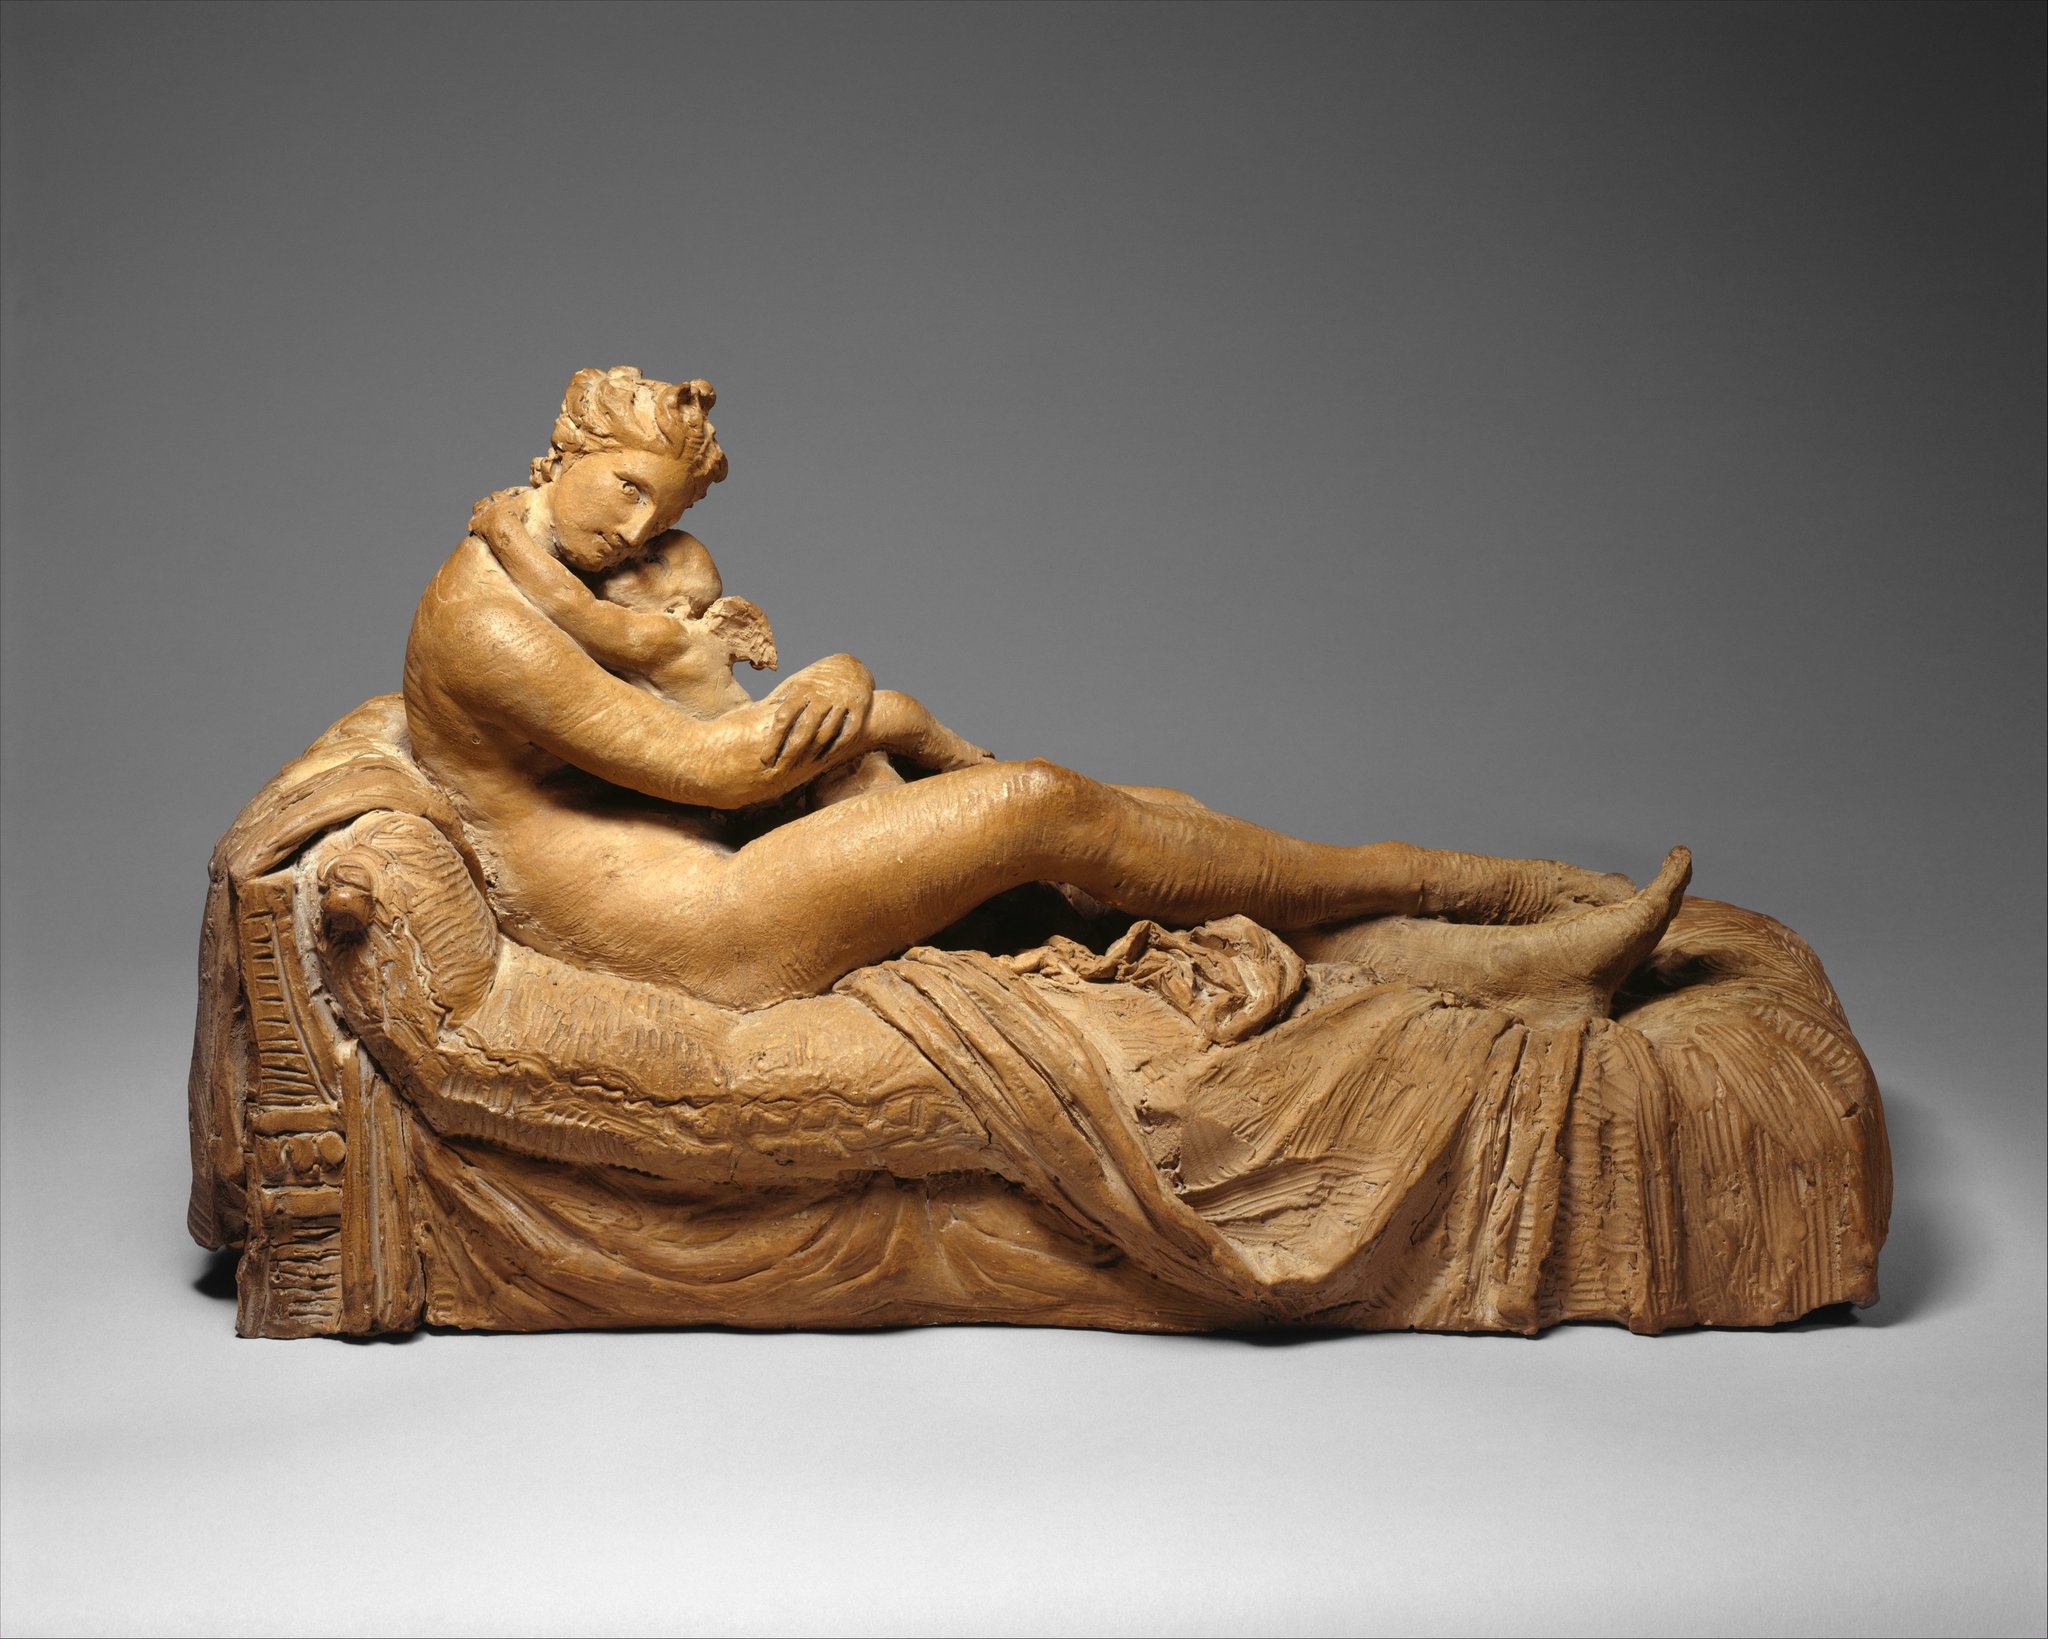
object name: statuette group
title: Venus and Cupid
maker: antonio canova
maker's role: artist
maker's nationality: italian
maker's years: 1757-1822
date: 1798-1799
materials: terracotta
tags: cupid,venus,beds